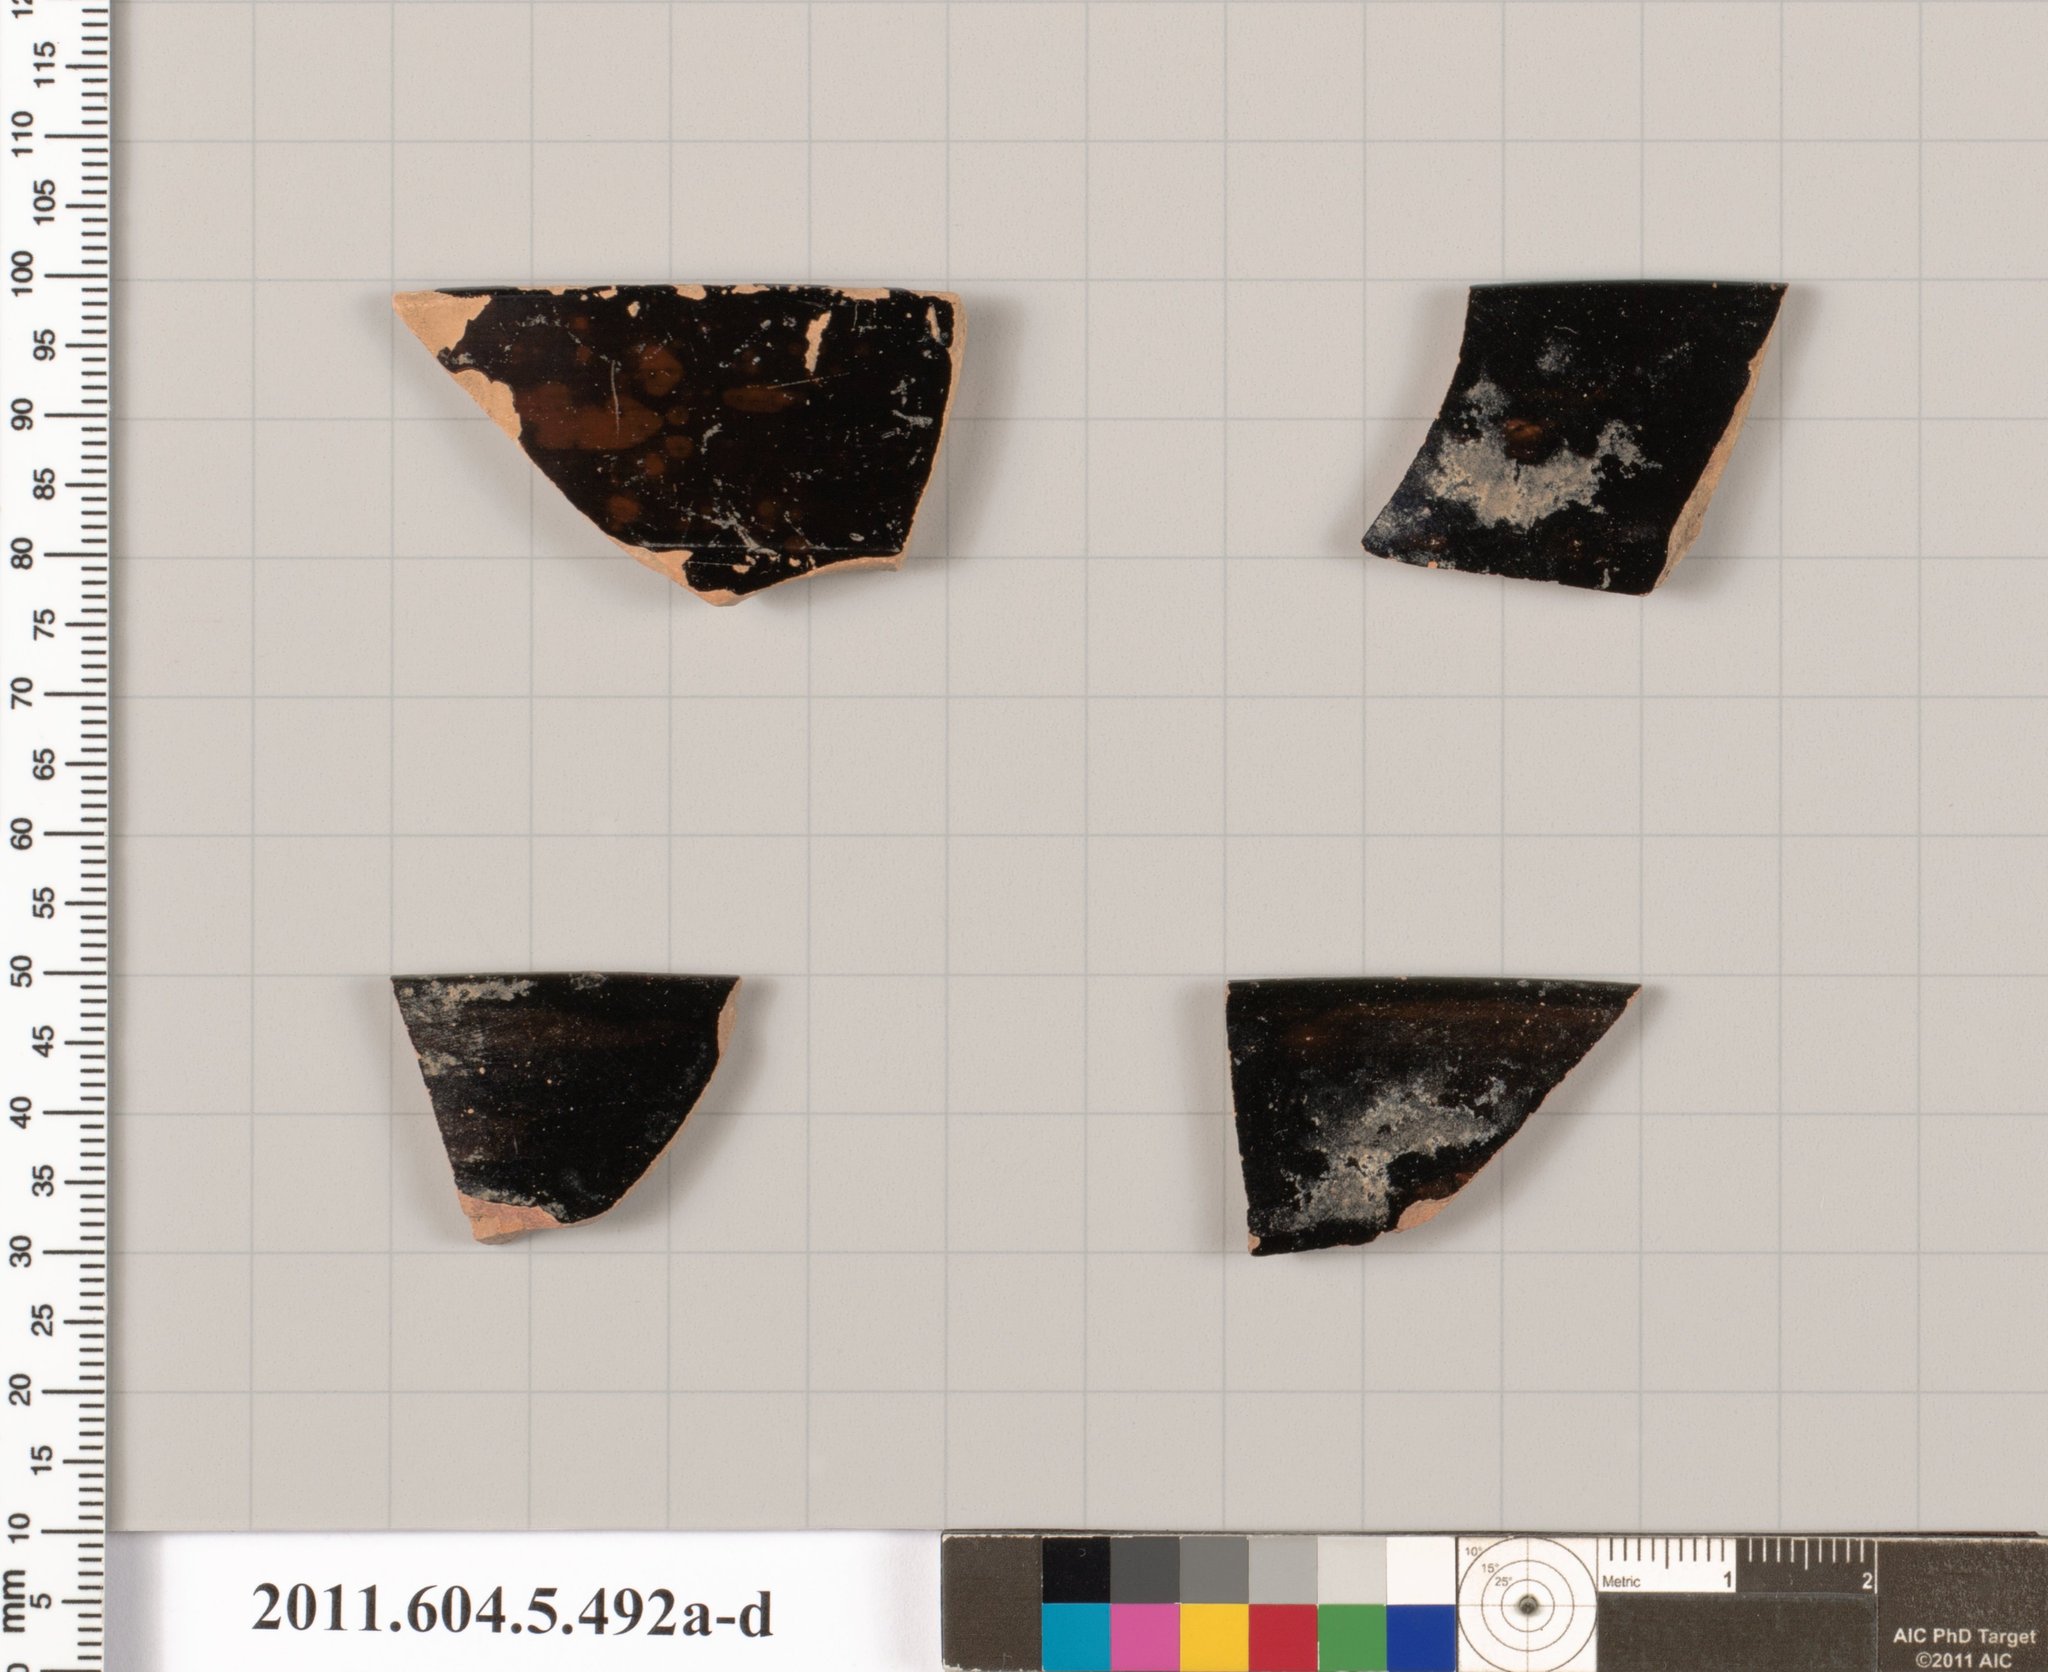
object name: kylix fragment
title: Terracotta rim fragments of kylikes (drinking cups)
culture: greek, attic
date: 600-401 BCE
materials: terracotta